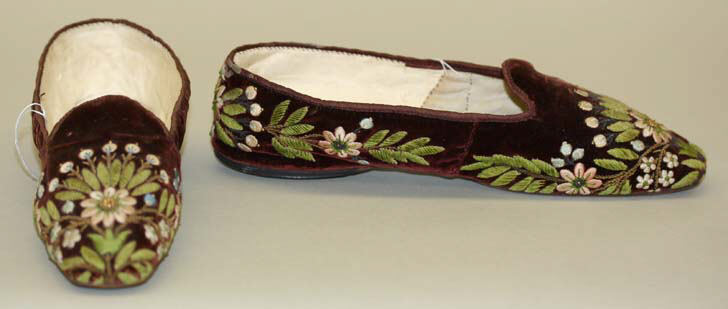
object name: slipper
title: Slippers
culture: french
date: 1830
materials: silk